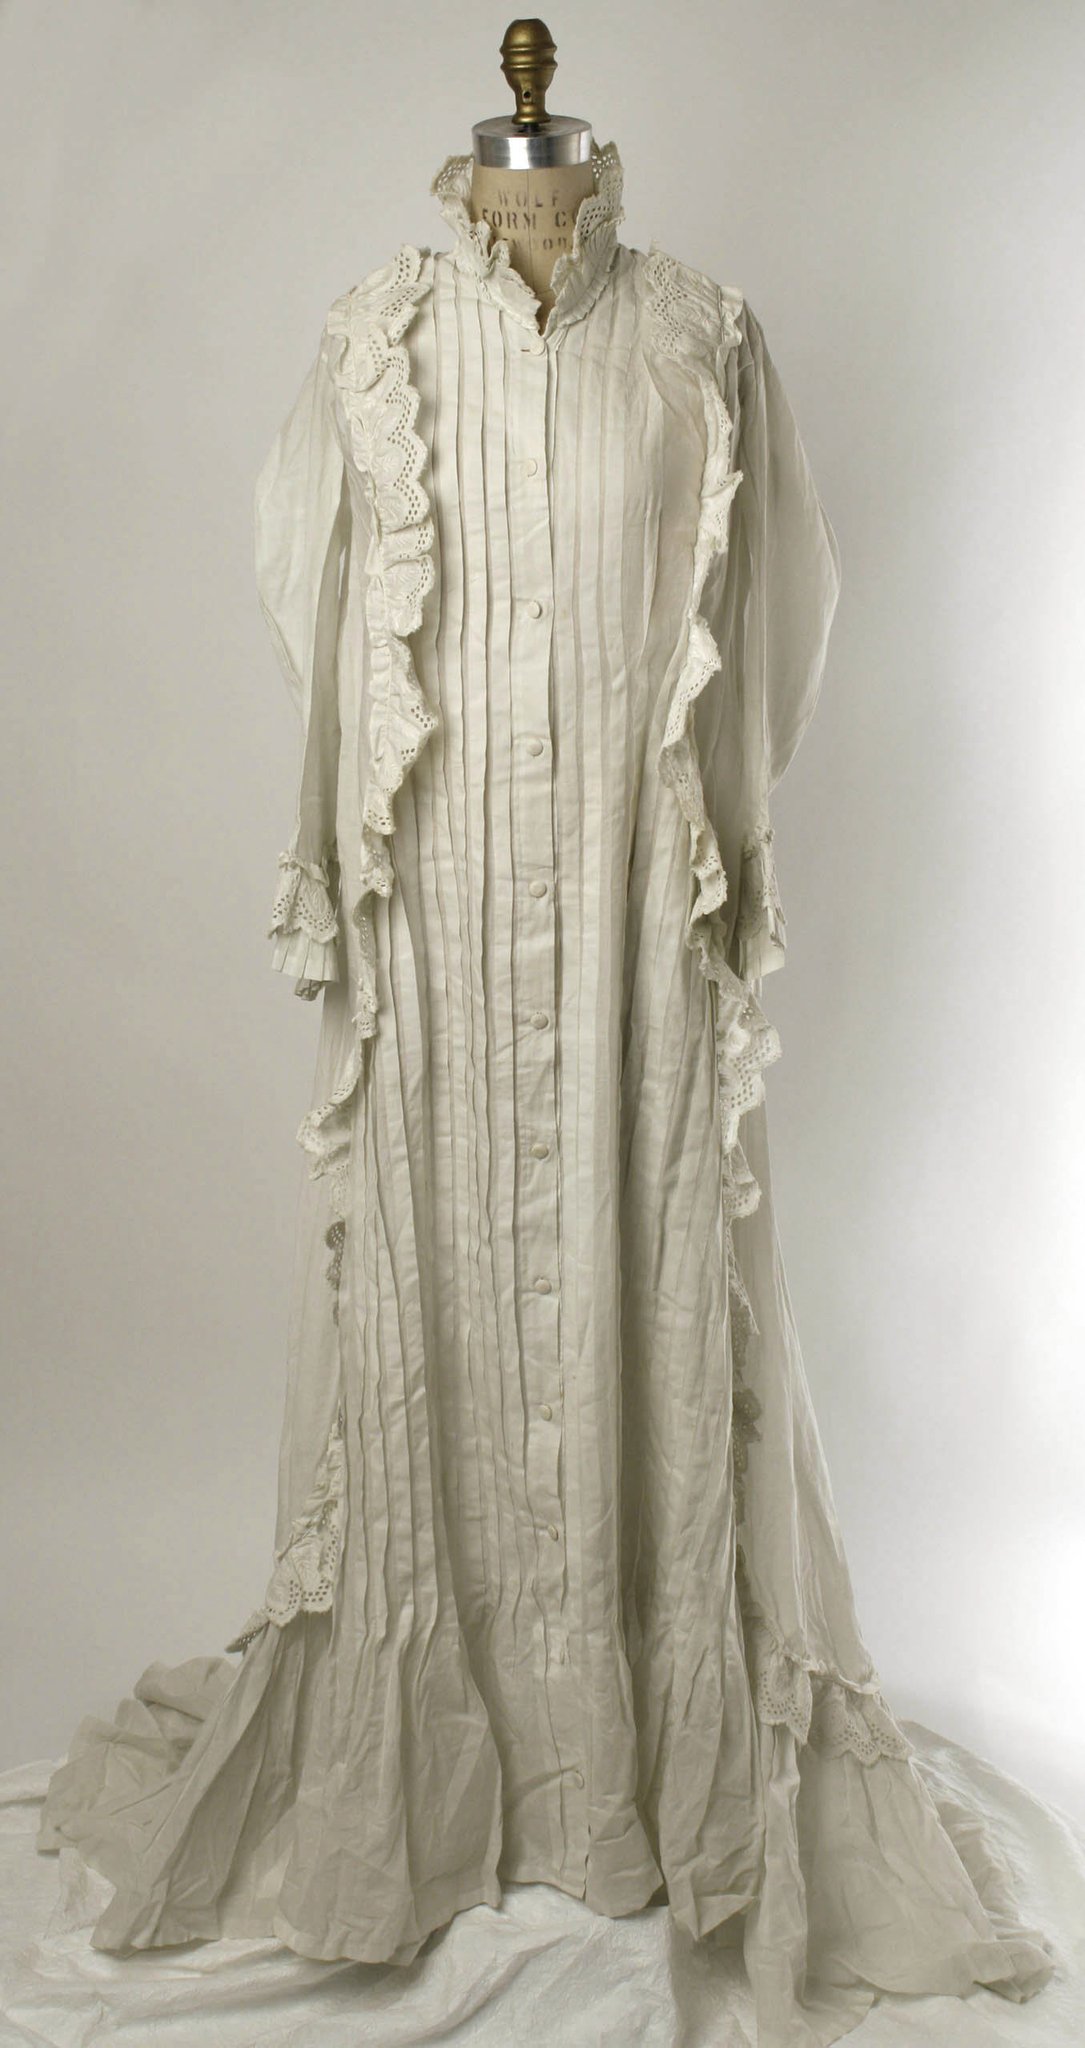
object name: negligée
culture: american or european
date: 1870-1879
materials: cotton